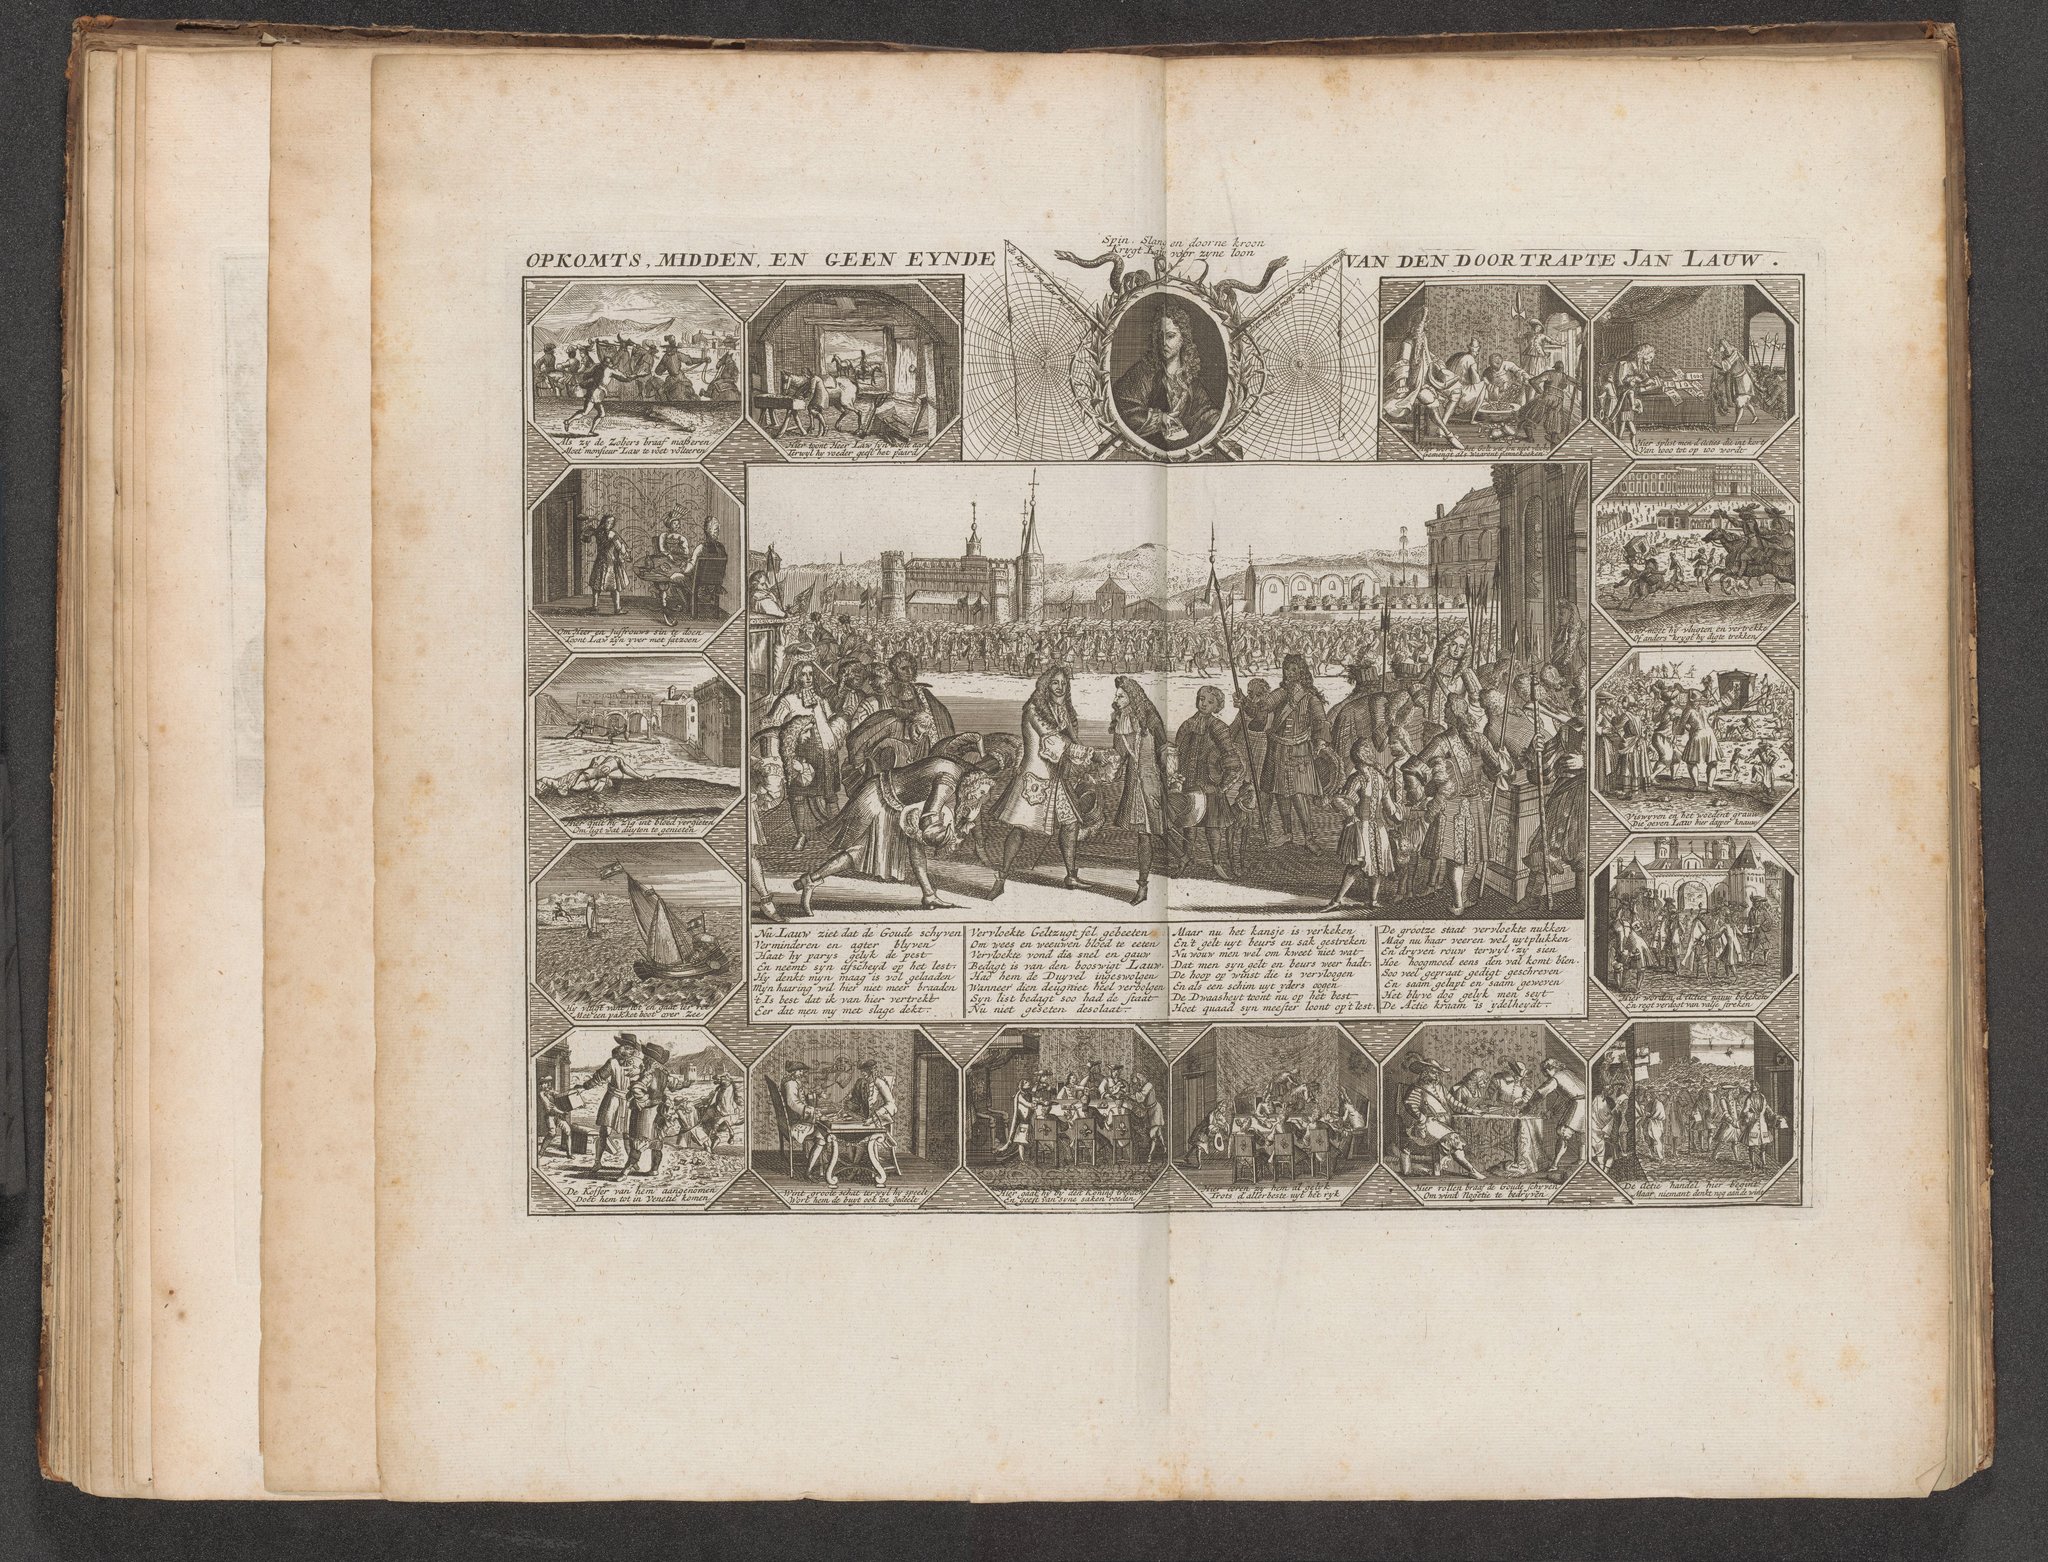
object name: cartoon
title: Opkomts, midden en geen eynde van den doortrapte Jan Lauw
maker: Anonymous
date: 1720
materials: paper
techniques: engraving, etching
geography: northern netherlands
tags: financial panic, paris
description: De opkomst maar nog geen val van John Law. Centraal een voorstelling van de aankomst en ontvangst van John Law in Parijs, met onderschrift van vier verzen. Omgeven door zestien kleinere scènes uit het leven van Law, boven zijn portret tussen spinnenwebben. Prent in de gebonden vierde uitgave (304 B 12) van Het Groote Tafereel der Dwaasheid met spotprenten op de Windhandel of Actiehandel van 1720.